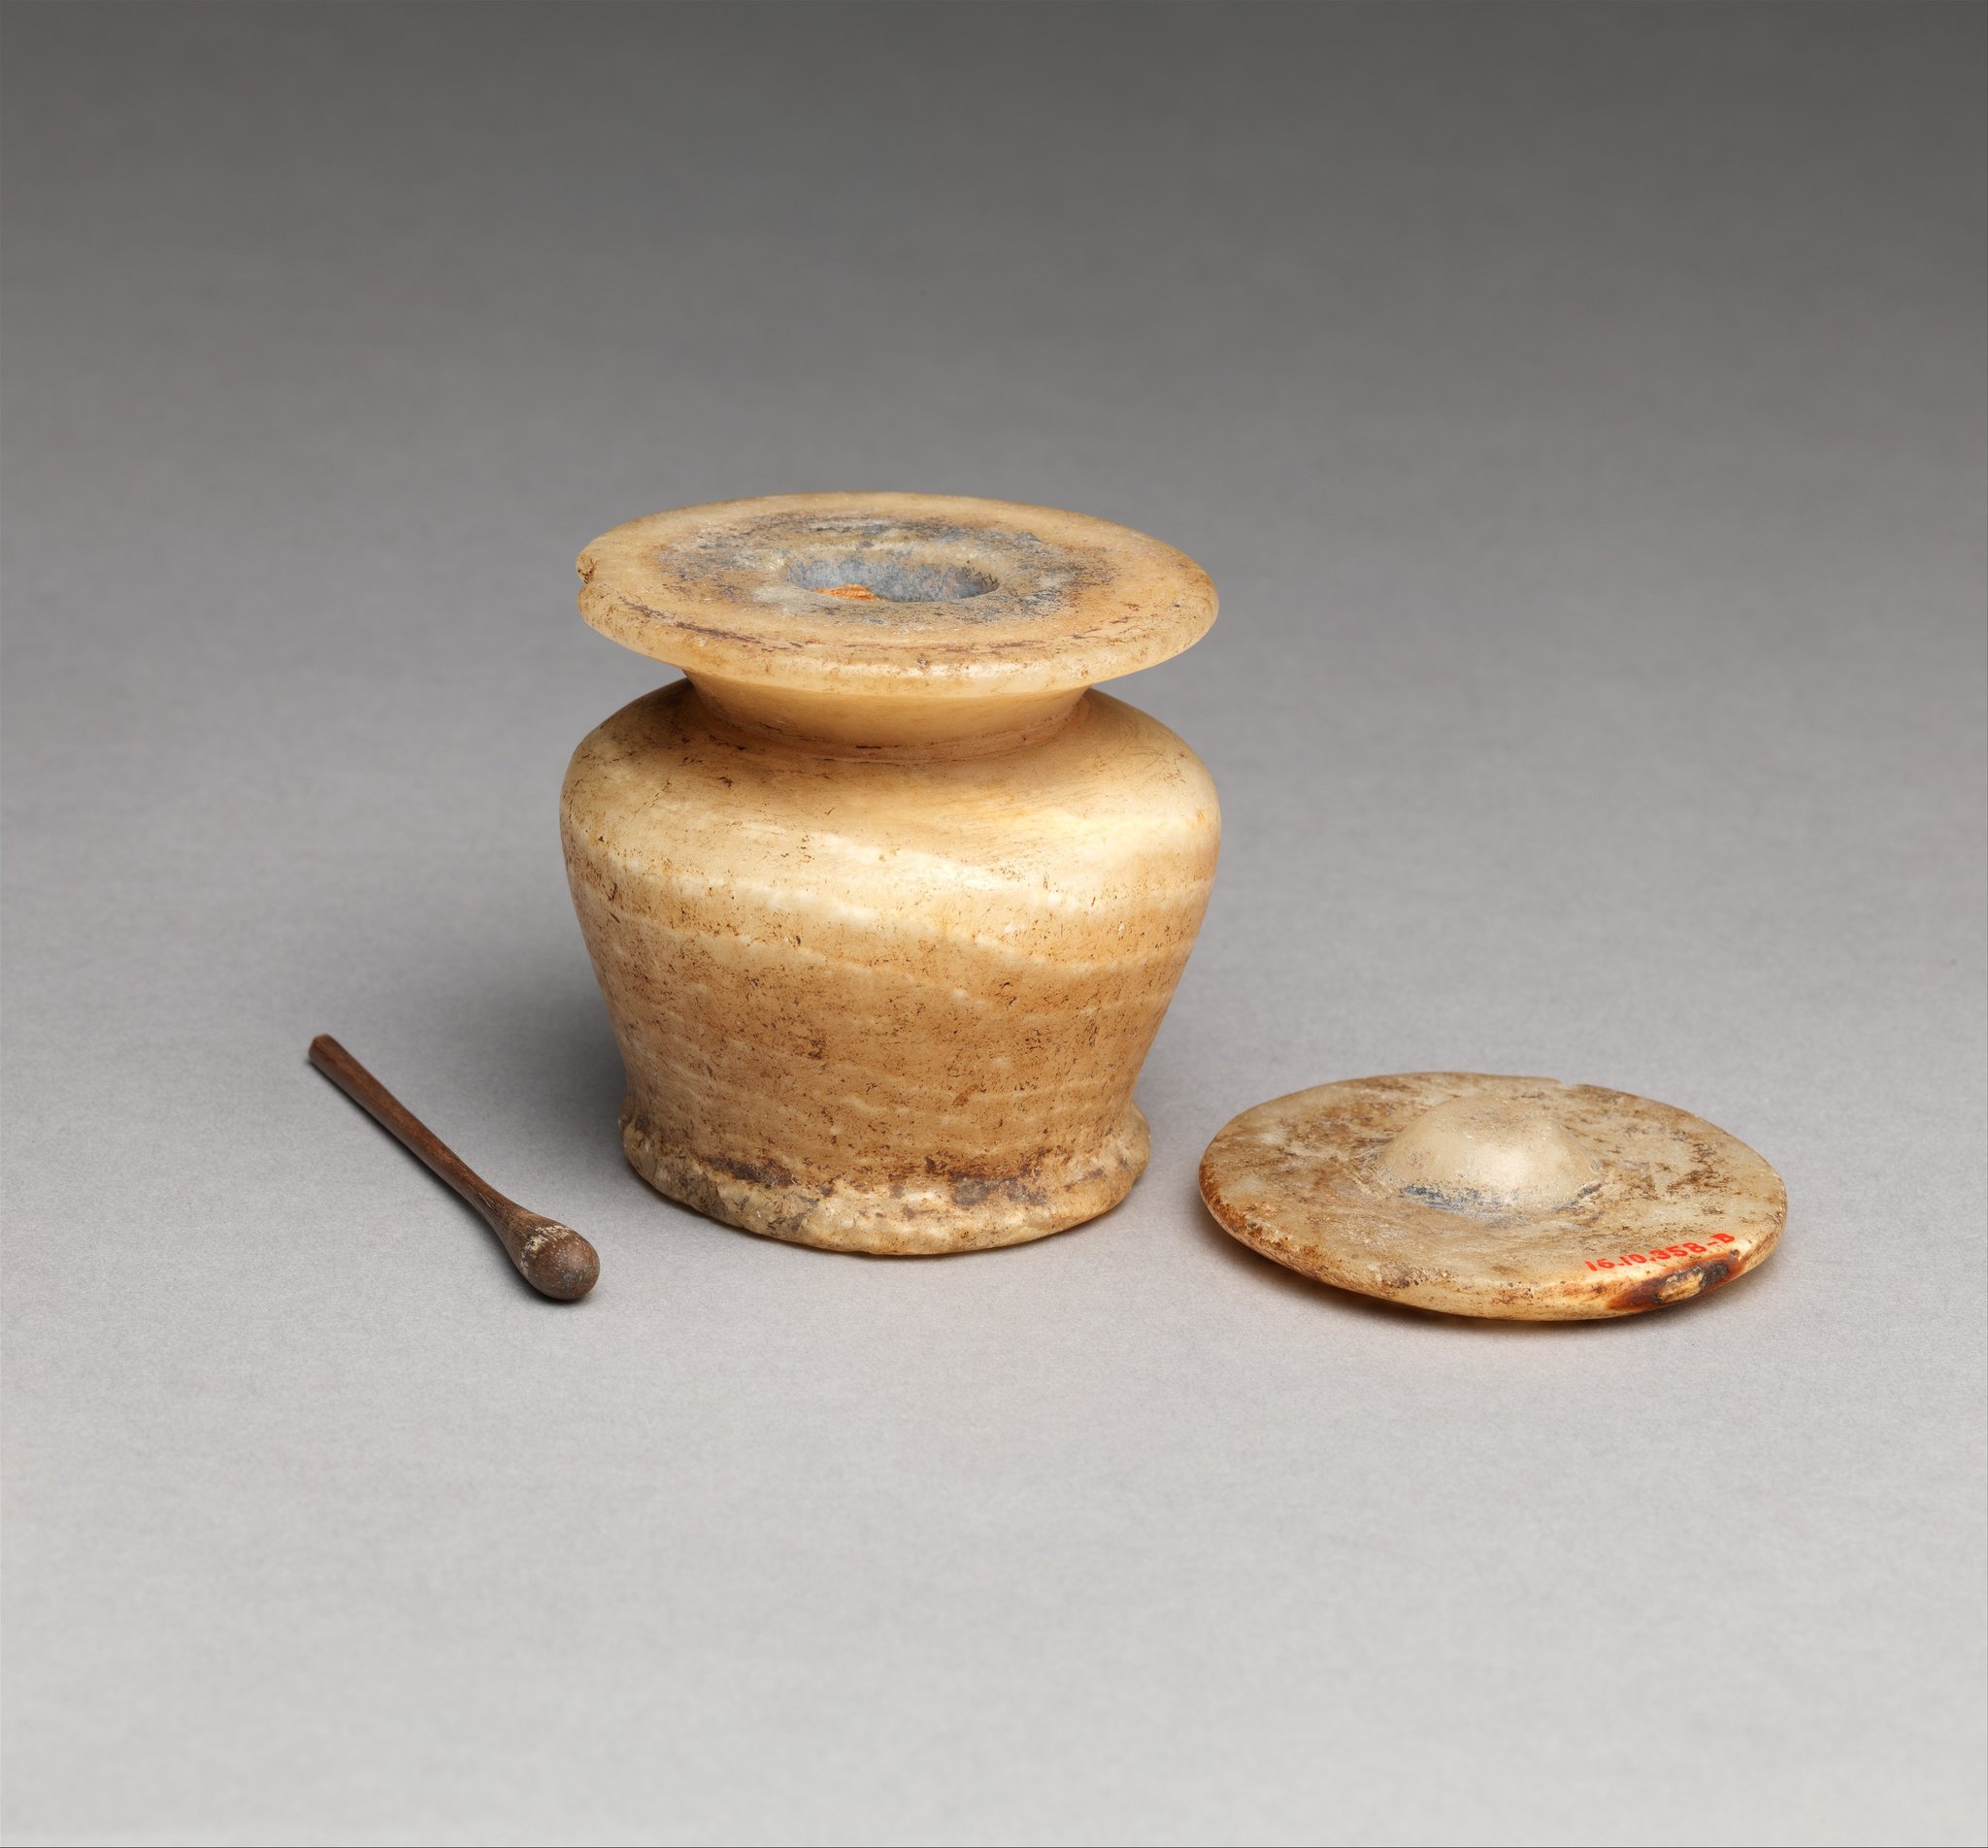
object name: kohl jar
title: Kohl Jar and Stick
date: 1635-1458 BCE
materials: stone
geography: egypt